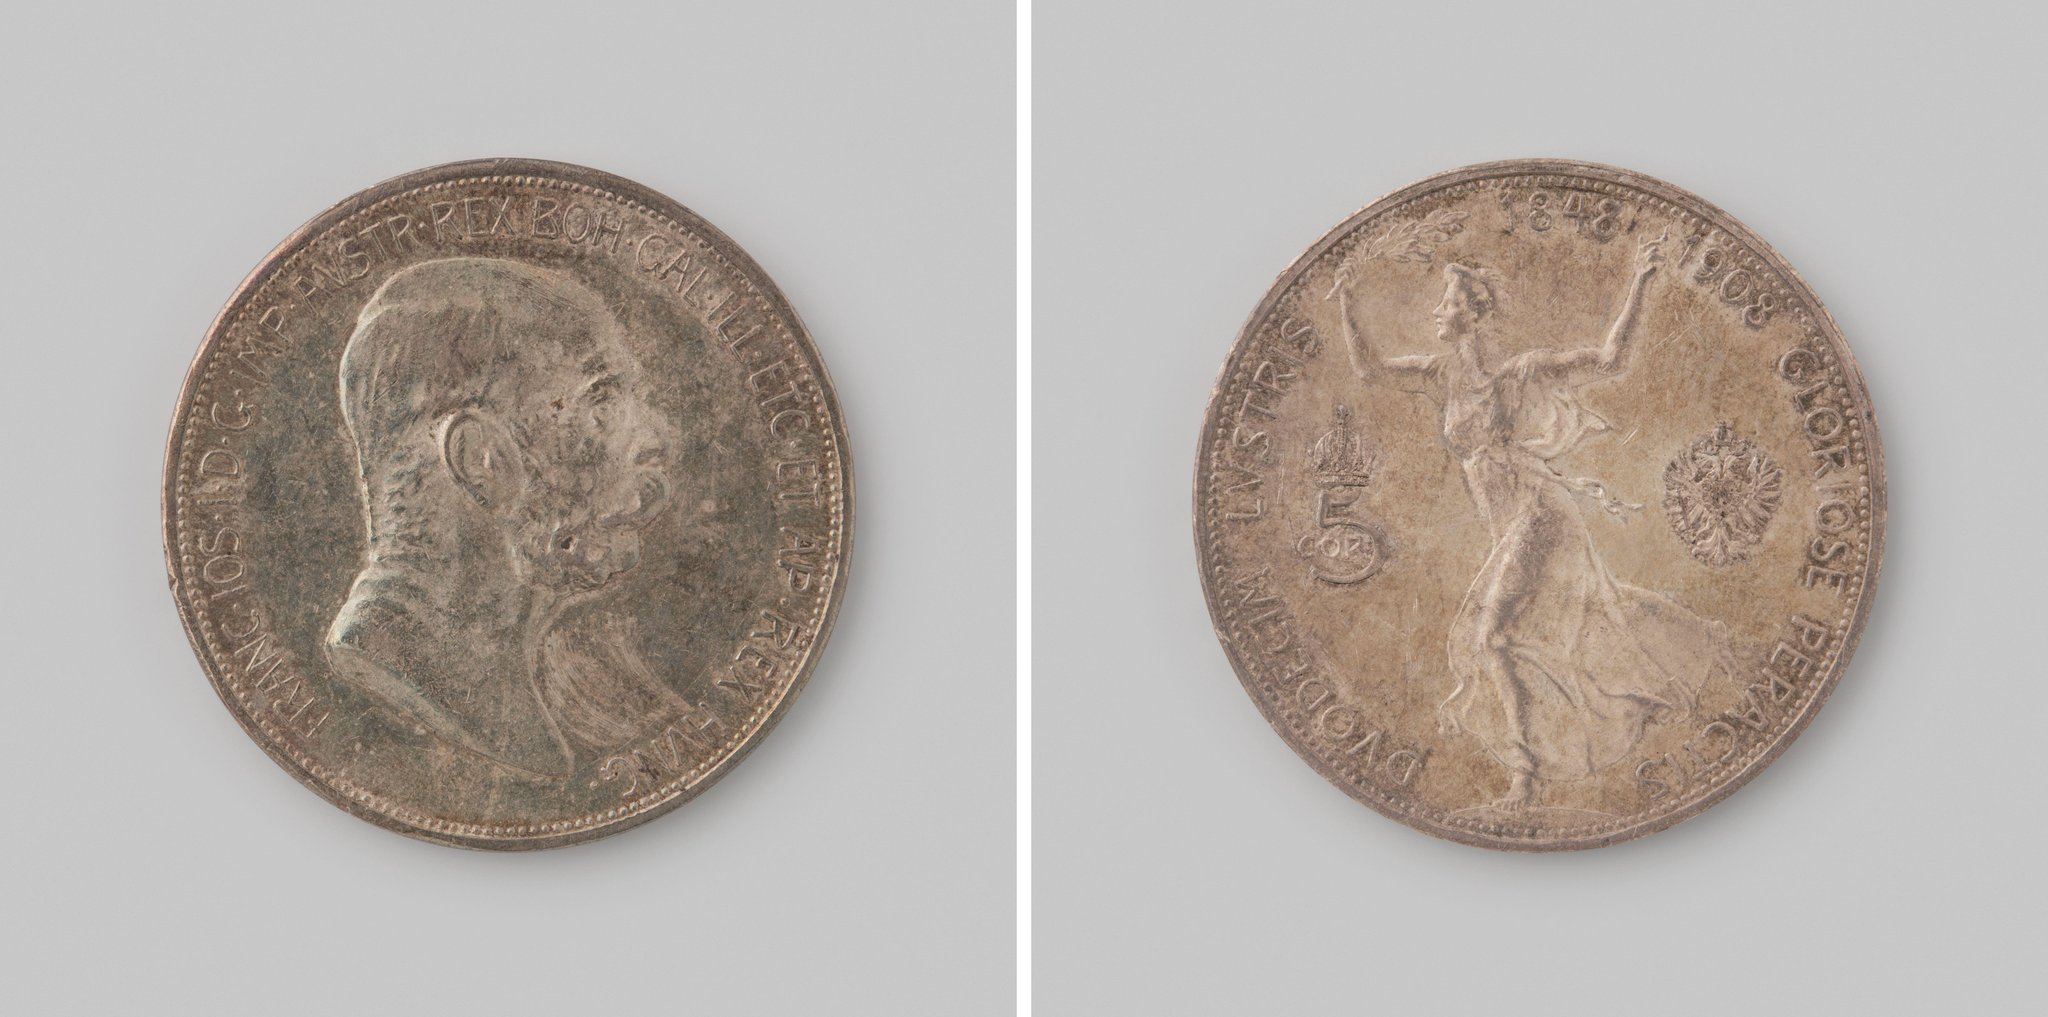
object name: coin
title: Keizerrijk Oostenrijk, 5 kronen, Franz Joseph,1908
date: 1908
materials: silver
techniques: striking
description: Zilveren munt ter gelegenheid van 60-jarig regeringsjubileum. Voorzijde: hoofd van de keizer naar rechts. Keerzijde: rennende vrouw naar links met in rechterhand tak. Rechts van haar wapen van Oostenrijk en links van haar waarde-aanduiding, waarboven keizerskroon. Jaartallen 1848 en 1908 in het omschrift. Randschrift.